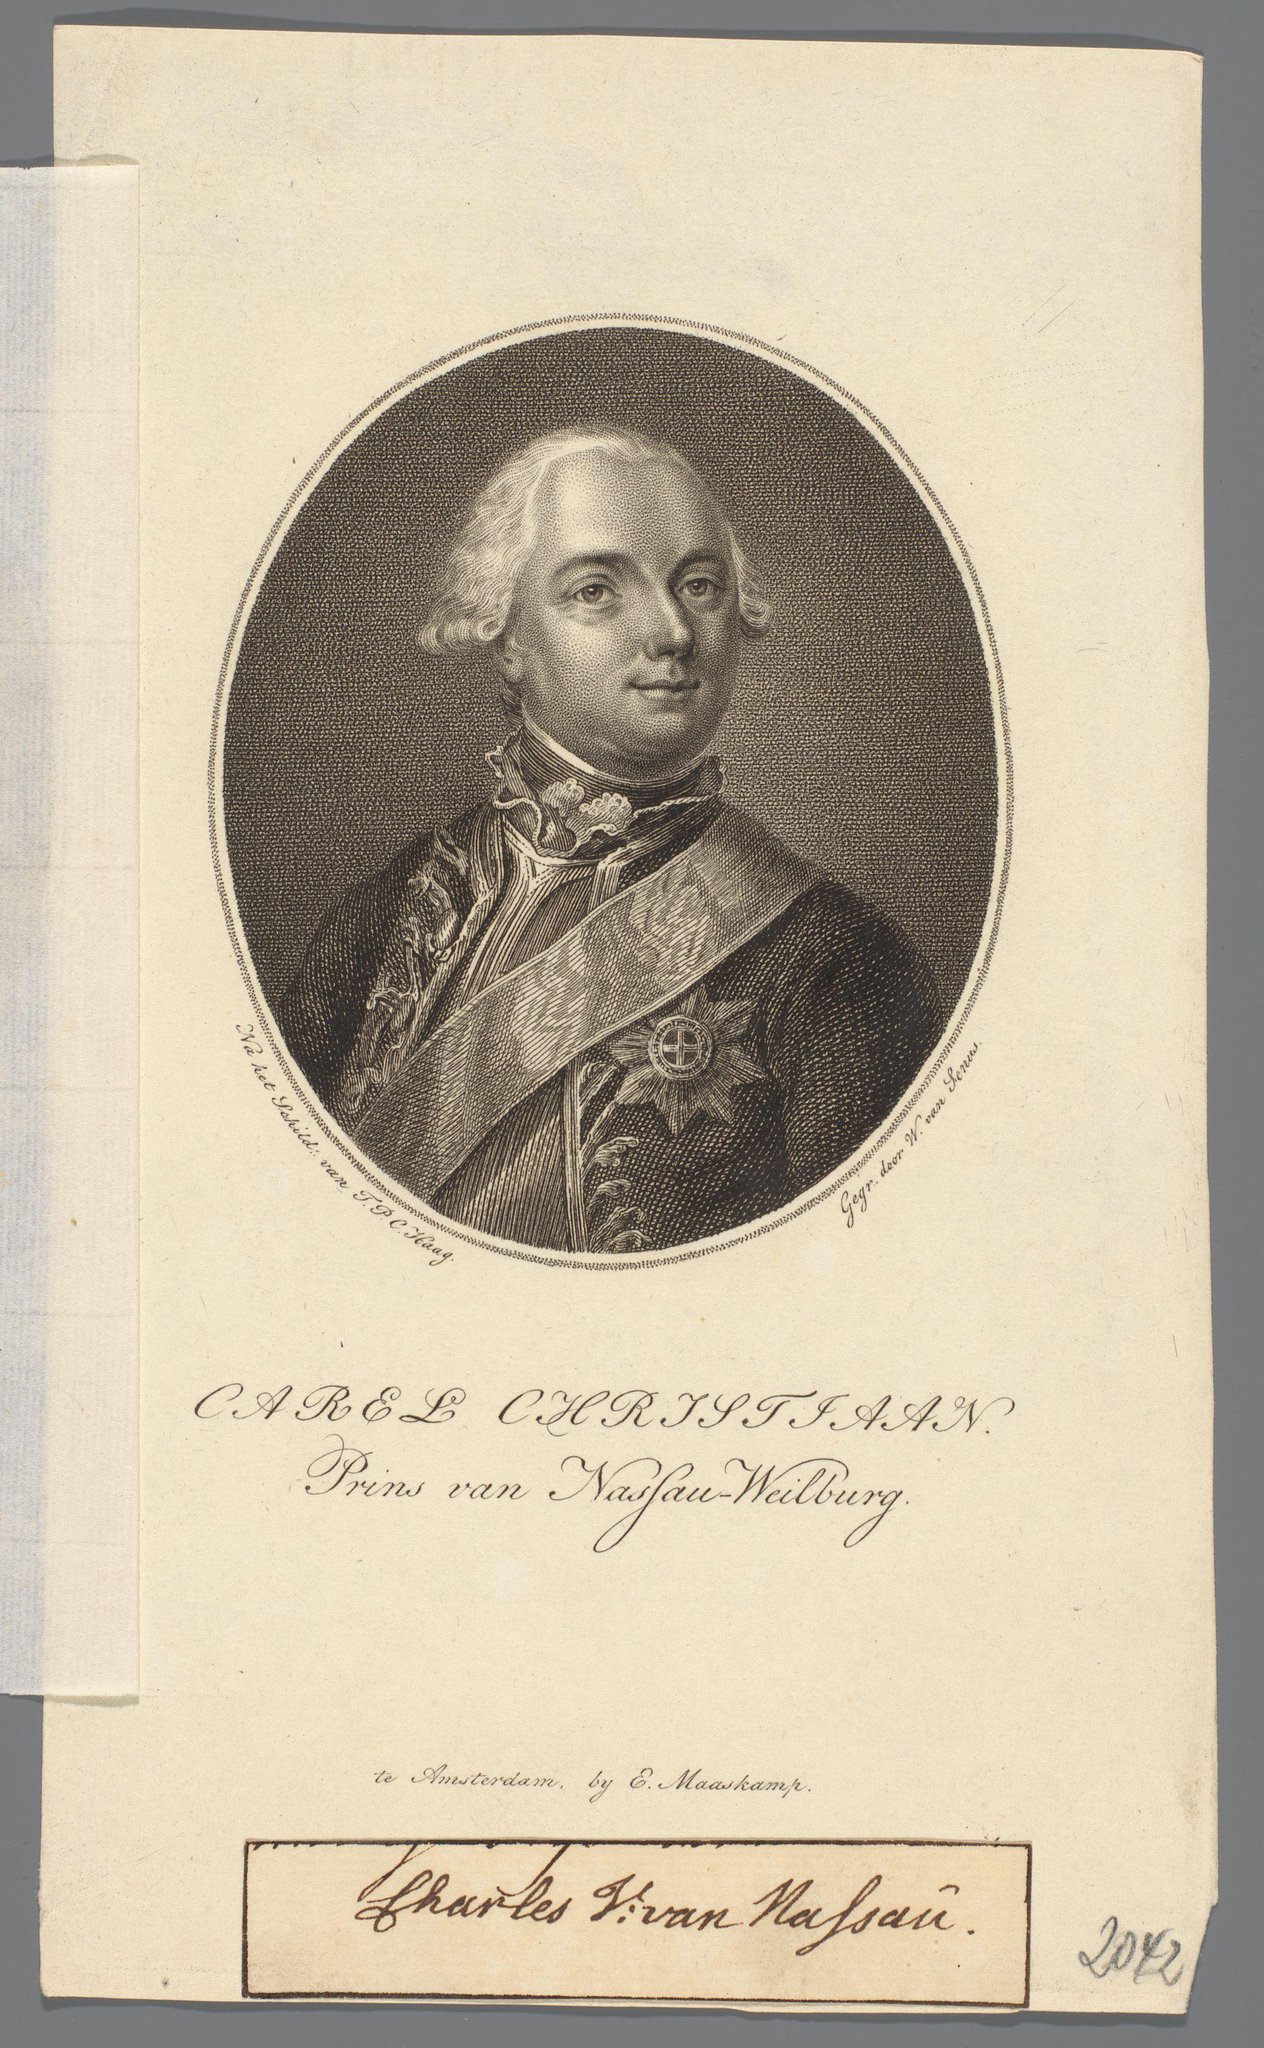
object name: print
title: Portret van Karel Christiaan van Nassau-Weilburg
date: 1787-1834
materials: paper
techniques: engraving, etching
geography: northern netherlands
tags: karel christiaan vorst van nassau-weilburg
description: Portret van Karel Christiaan in een ovaal. In de ondermarge zijn naam en titel. In de ondermarge zijn titel. Daaronder losse opgeplakte handtekening met pen.